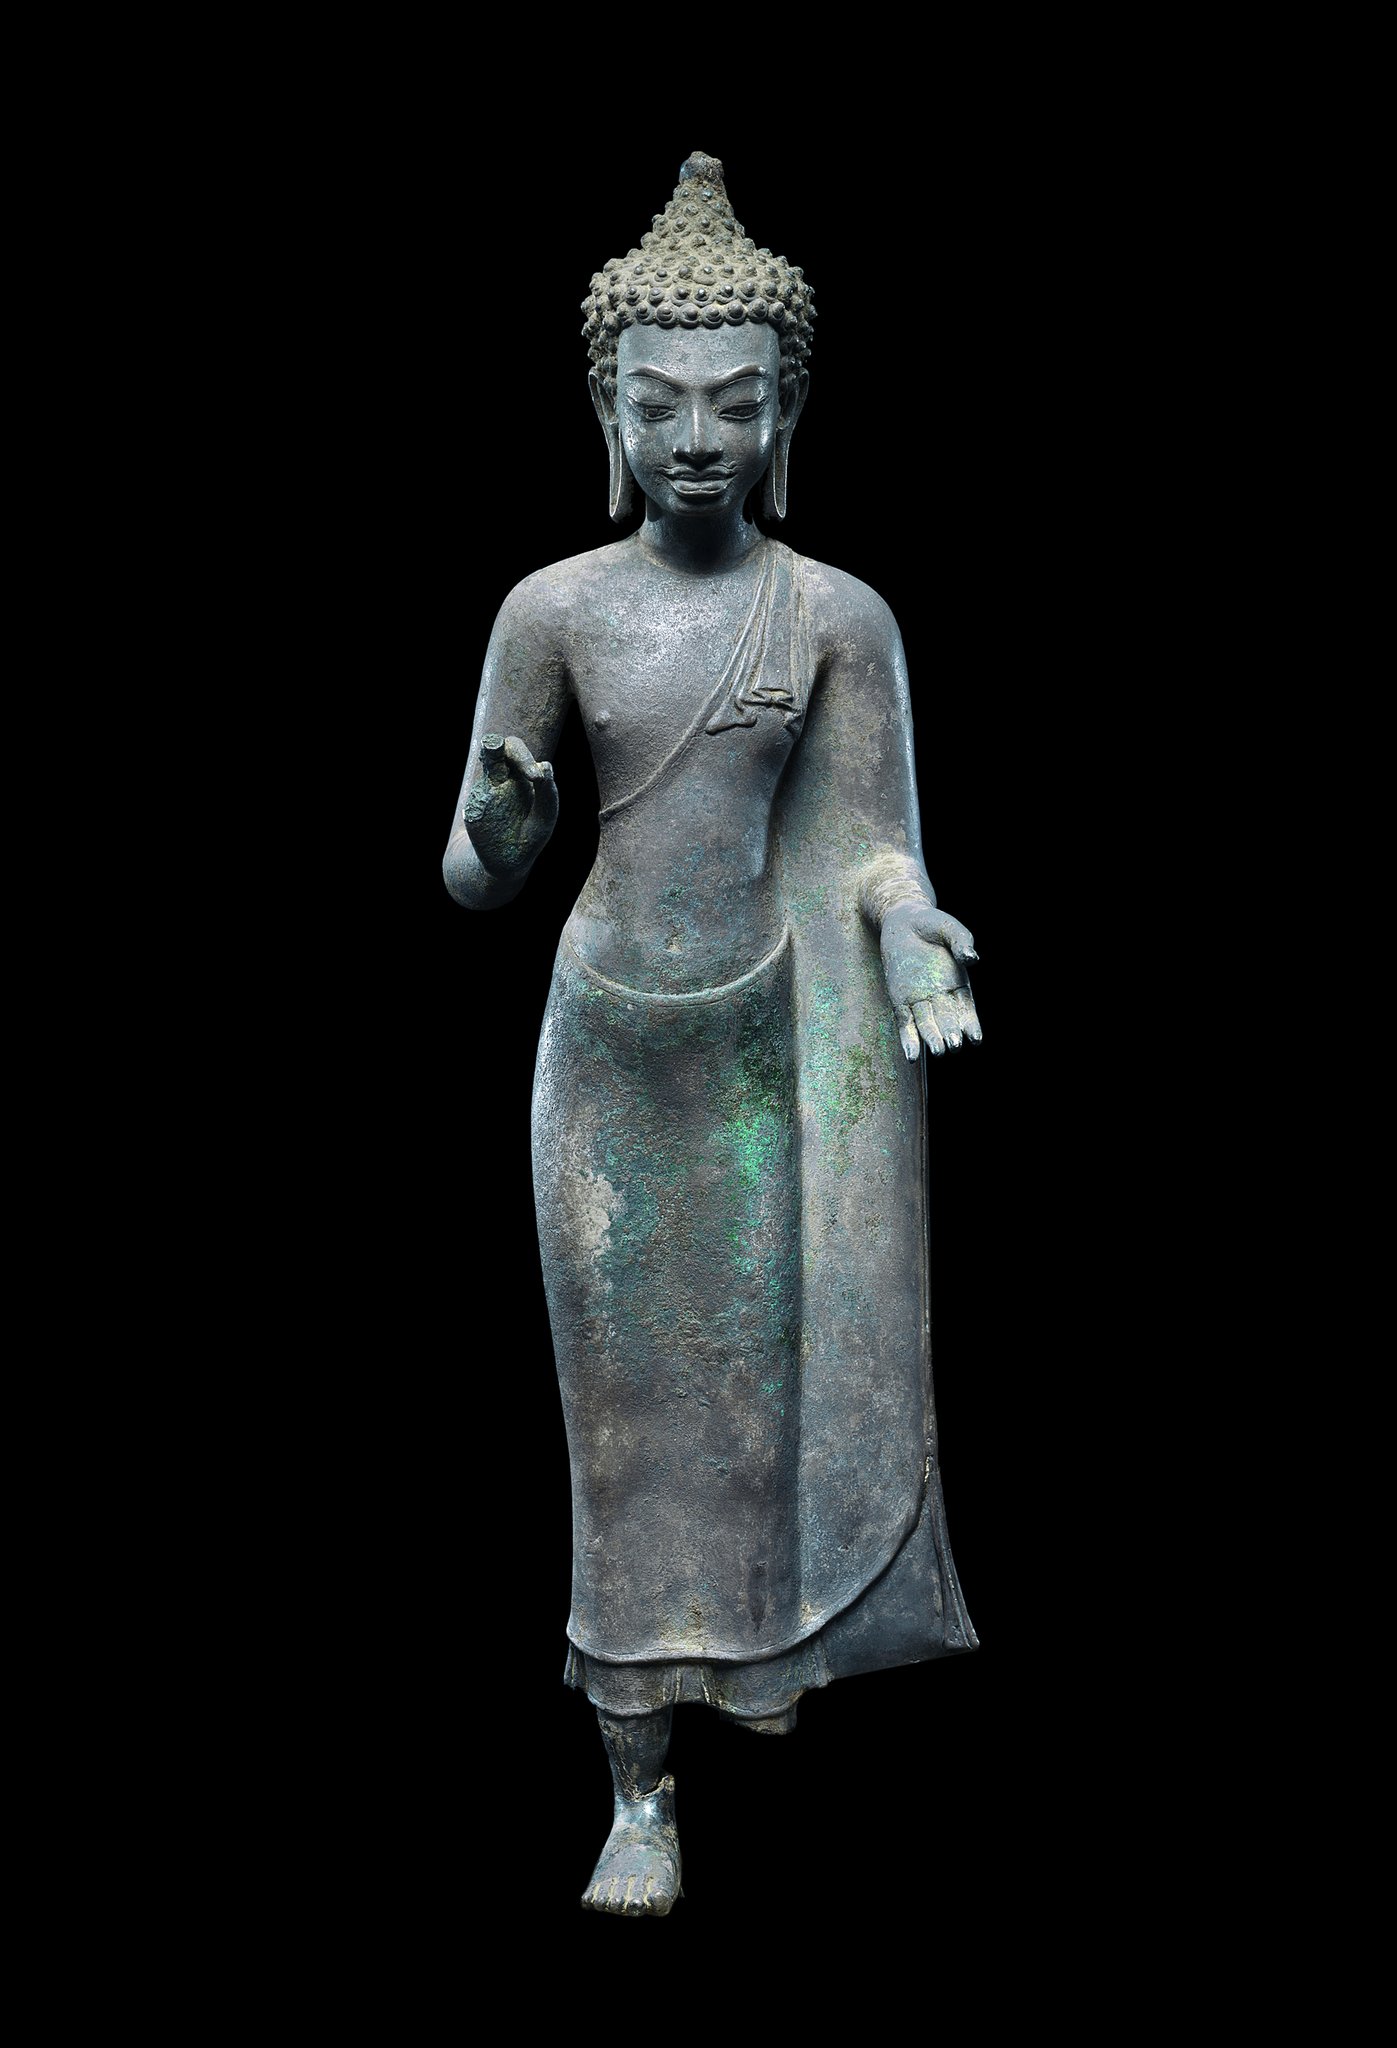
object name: figure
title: Buddha Preaching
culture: thai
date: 701-833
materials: alloy, silver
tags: buddhism,buddha